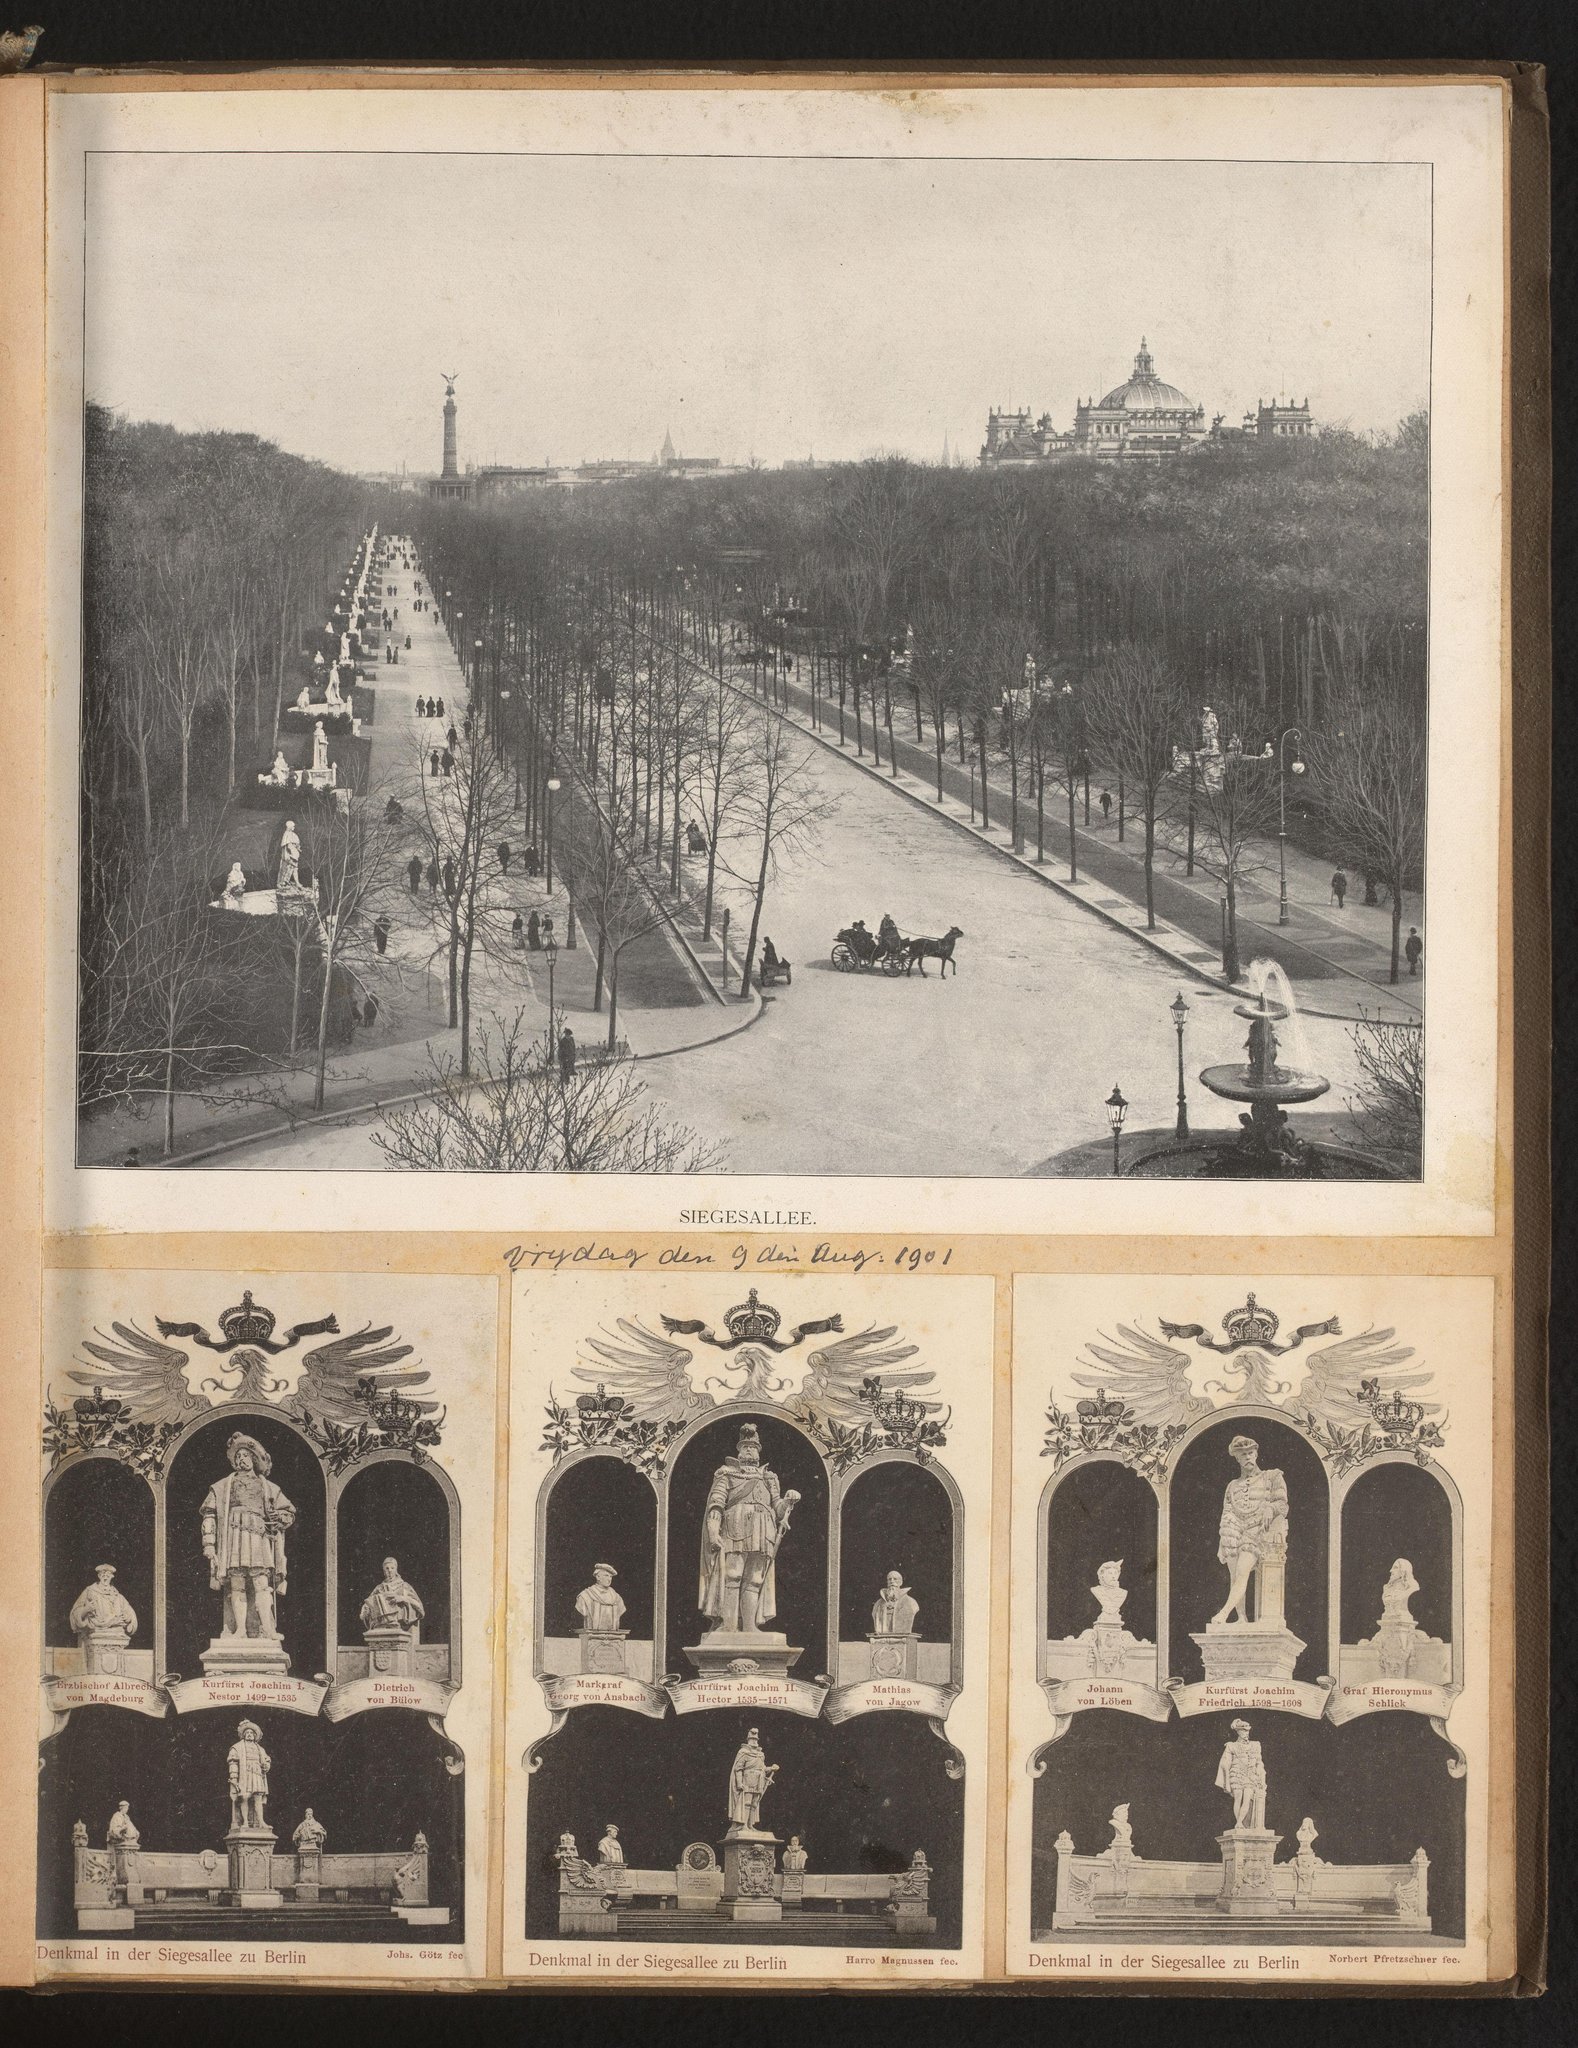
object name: photomechanical print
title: Gezicht op de Siegesallee en beelden aldaar, Berlijn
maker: Anonymous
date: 1896-1901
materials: paper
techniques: photograph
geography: berlin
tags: piece of sculpture, reproduction of a piece of sculpture, public gardens, park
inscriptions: inscription: ‘Denkmal in der Siegesallee zu Berlin (...)’, inscription: ‘Vrijdag den 9den Aug: 1901’, title: ‘Siegesallee’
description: Deze fotomechanische afdrukken maken deel uit van een album.